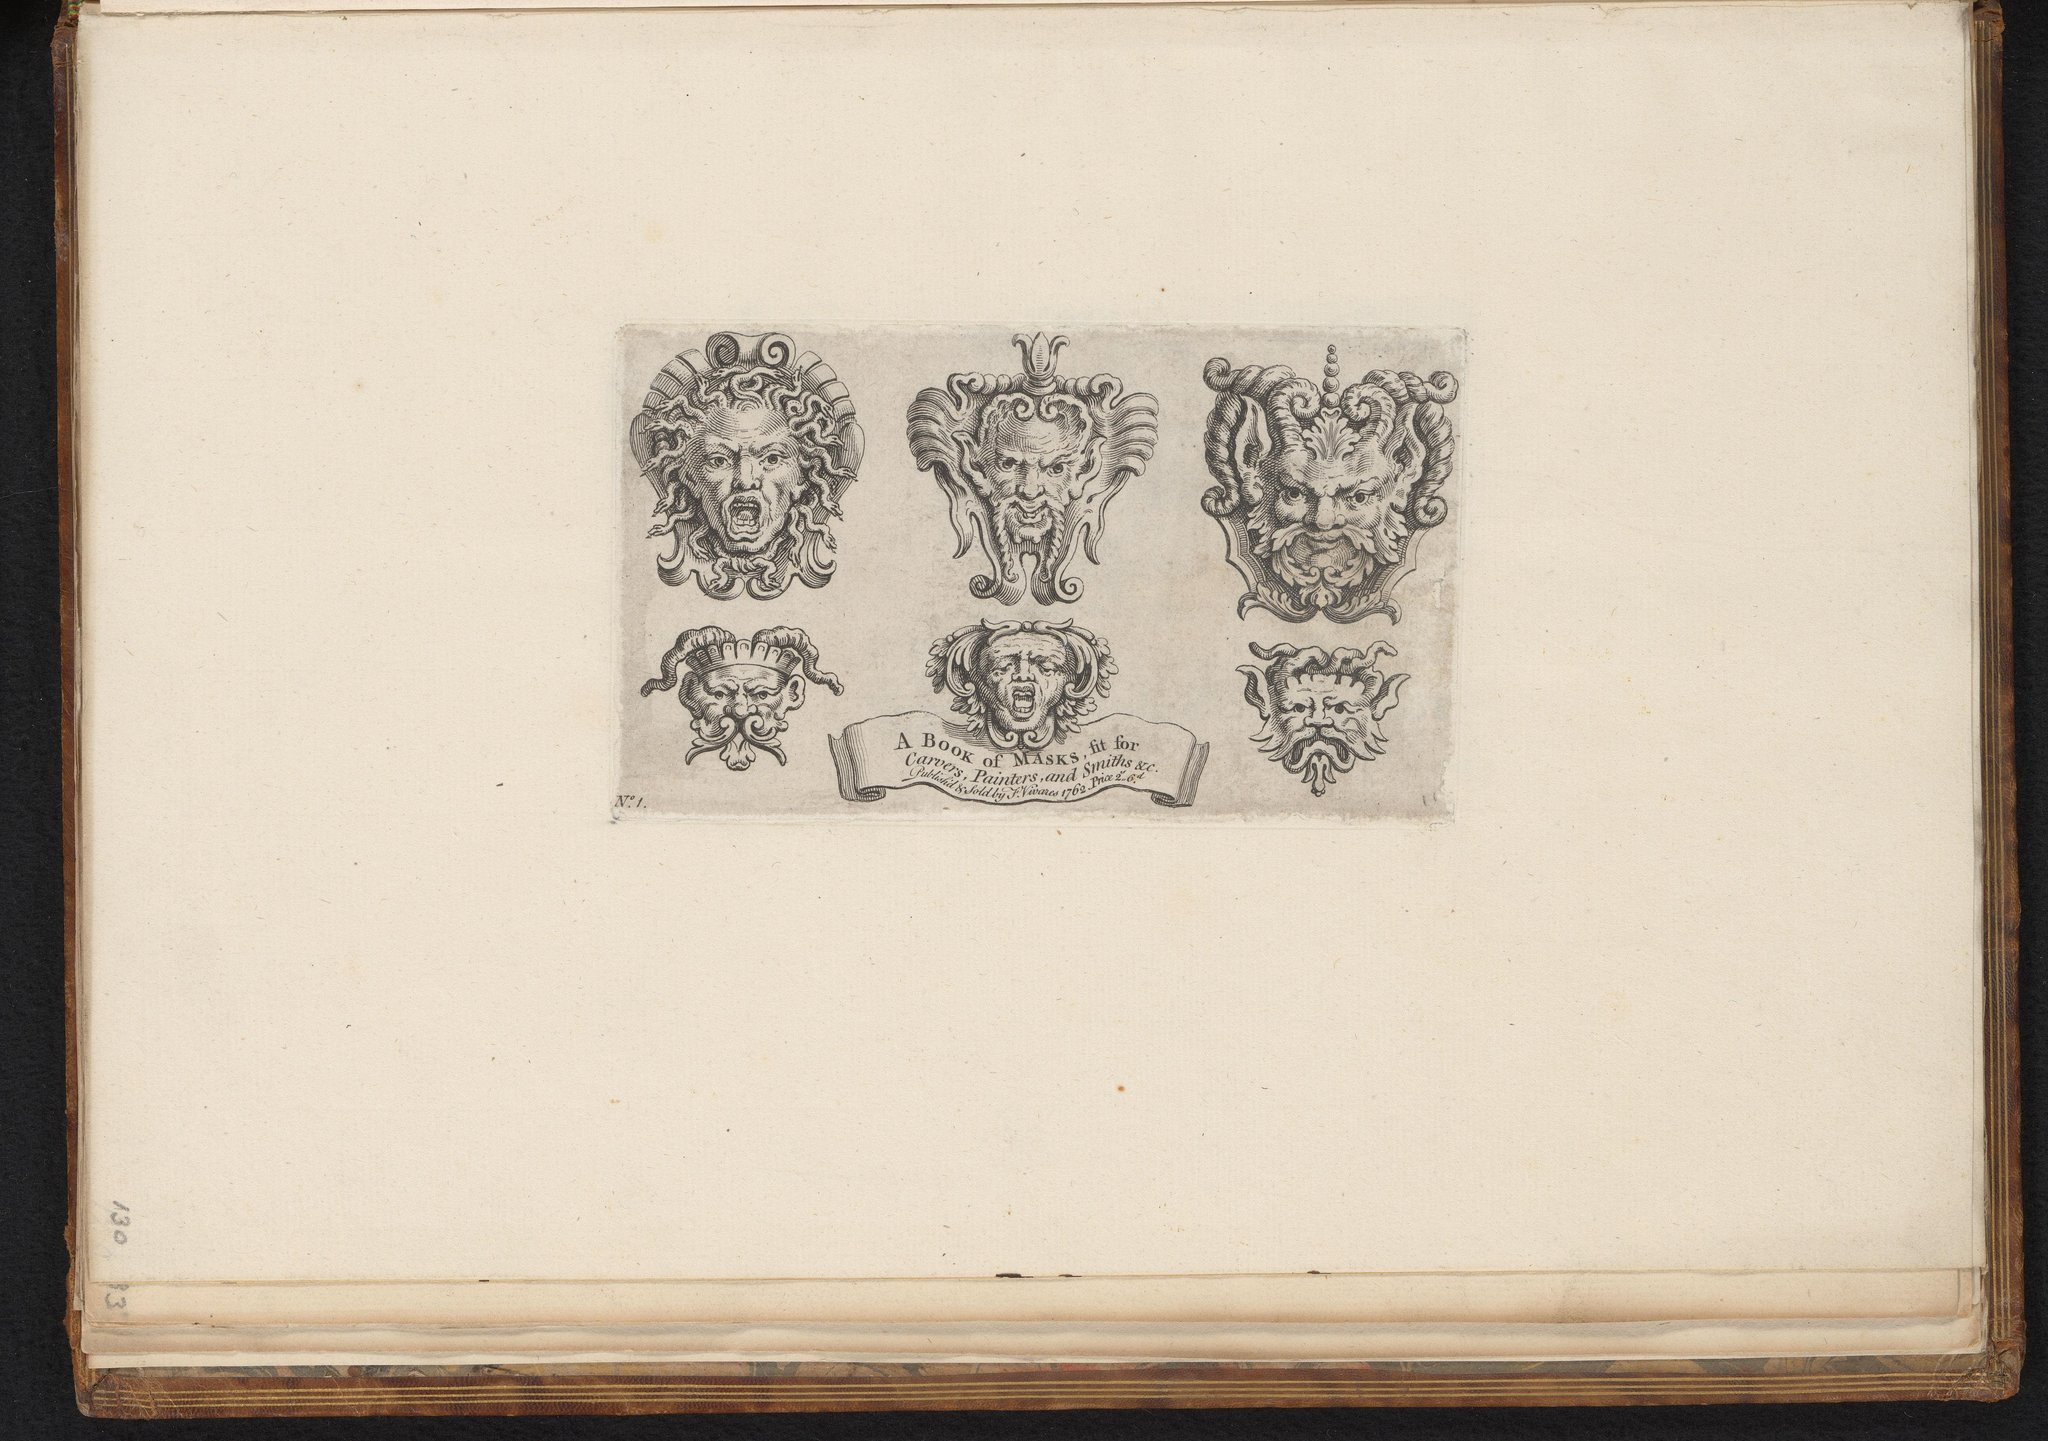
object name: print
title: Maskers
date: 1762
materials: paper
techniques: etching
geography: london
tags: mask, mascaron ~ ornament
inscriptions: collector's mark: Lugt 2228, collector's mark: Lugt 2760